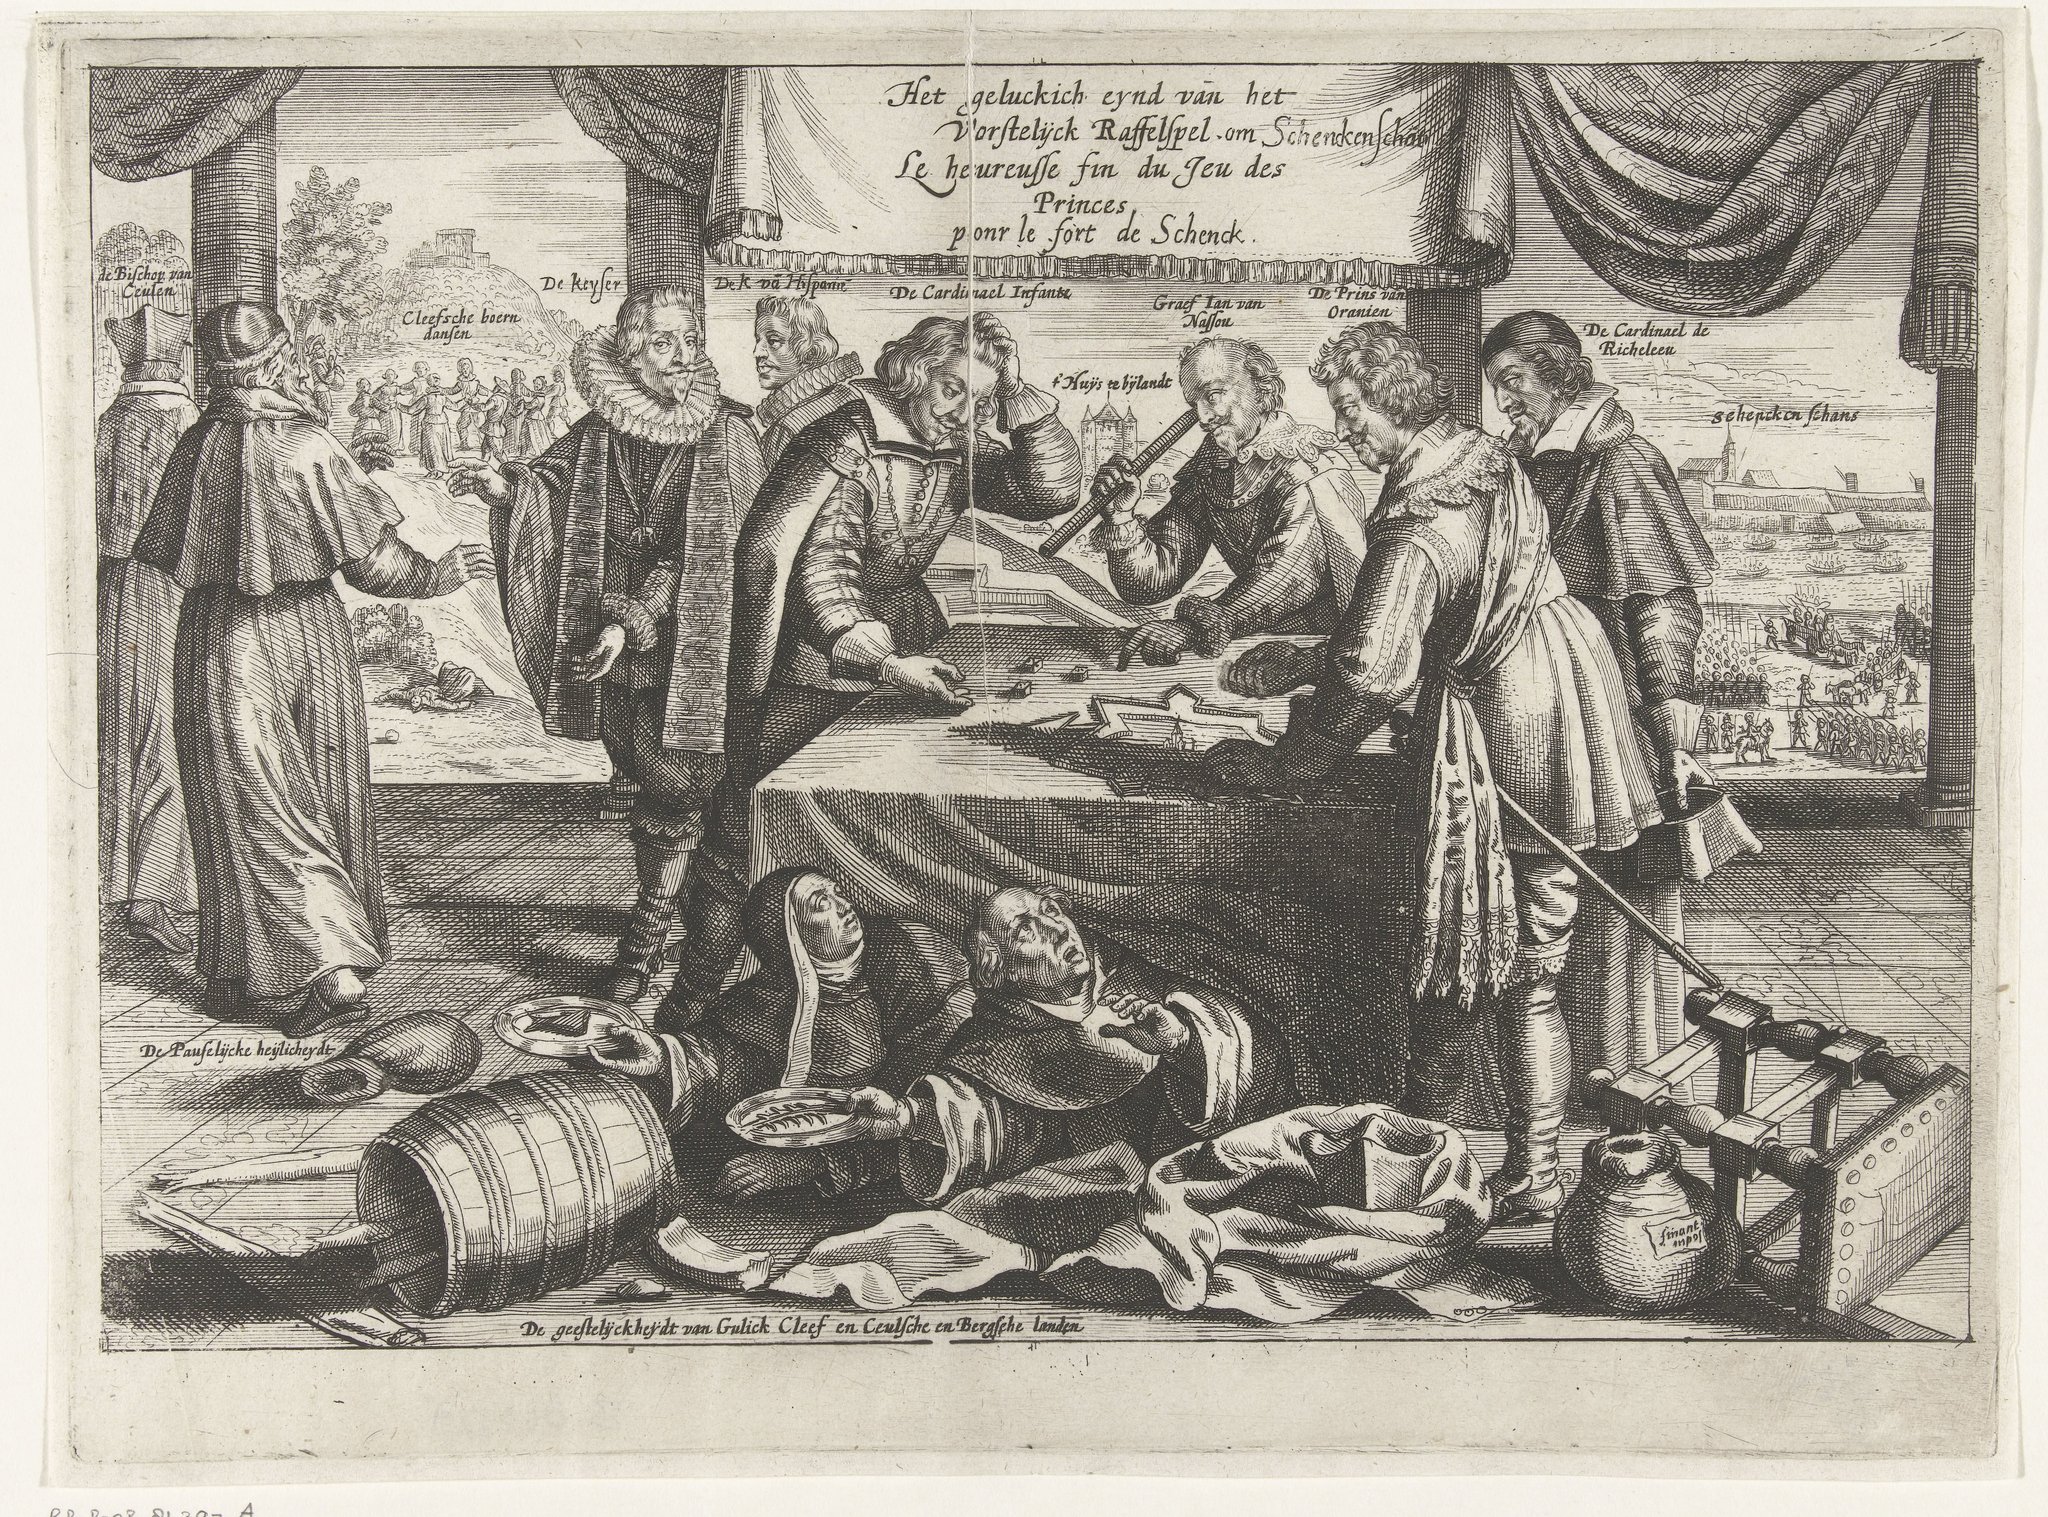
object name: cartoon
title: Het geluckich eynd van het Vorstelijck Raffelspel om Schenckenschants / Le heureusse fin du Jeu des Princes pour le fort de Schenck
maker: Anonymous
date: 1636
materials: paper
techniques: engraving, etching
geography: northern netherlands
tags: the hague, frederick henry (prince of orange), filips iv (koning van spanje), vienna, ferdinand ii (duits keizer), clergyman, urbanus viii, ferdinand van beieren, paris, armand-jean du plessis hertog van richelieu, landvoogd der zuidelijke nederlanden ferdinand van oostenrijk, capture of city (after the siege), dice-games, political caricatures and satires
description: Spotprent op de strijd om Schenckenschans in de jaren 1635-1636. Het einde van het spel om de schans. Frederik Hendrik en de kardinaal infant Ferdinand dobbelen aan een tafel om het fort. De stadhouder gooit de winnende worp. De kardinaal infant krabt zich op het hoofd, graaf Johan van Nassau kijkt naar de stenen door een verrekijker. Links vertrekken de paus, de bisschop Keulen, de koning van Spanje en de keizer. Rechts kijkt kardinaal Richelieu toe. Links op de achtergrond dansen de Kleefse boeren van blijdschap. Van onder de tafel komen een priester en een non tevoorschijn. Rechts op de achtergrond de verovering van het fort door het Staatse leger op 29 april 1636. Bij de prent behoort een los tekstblad.